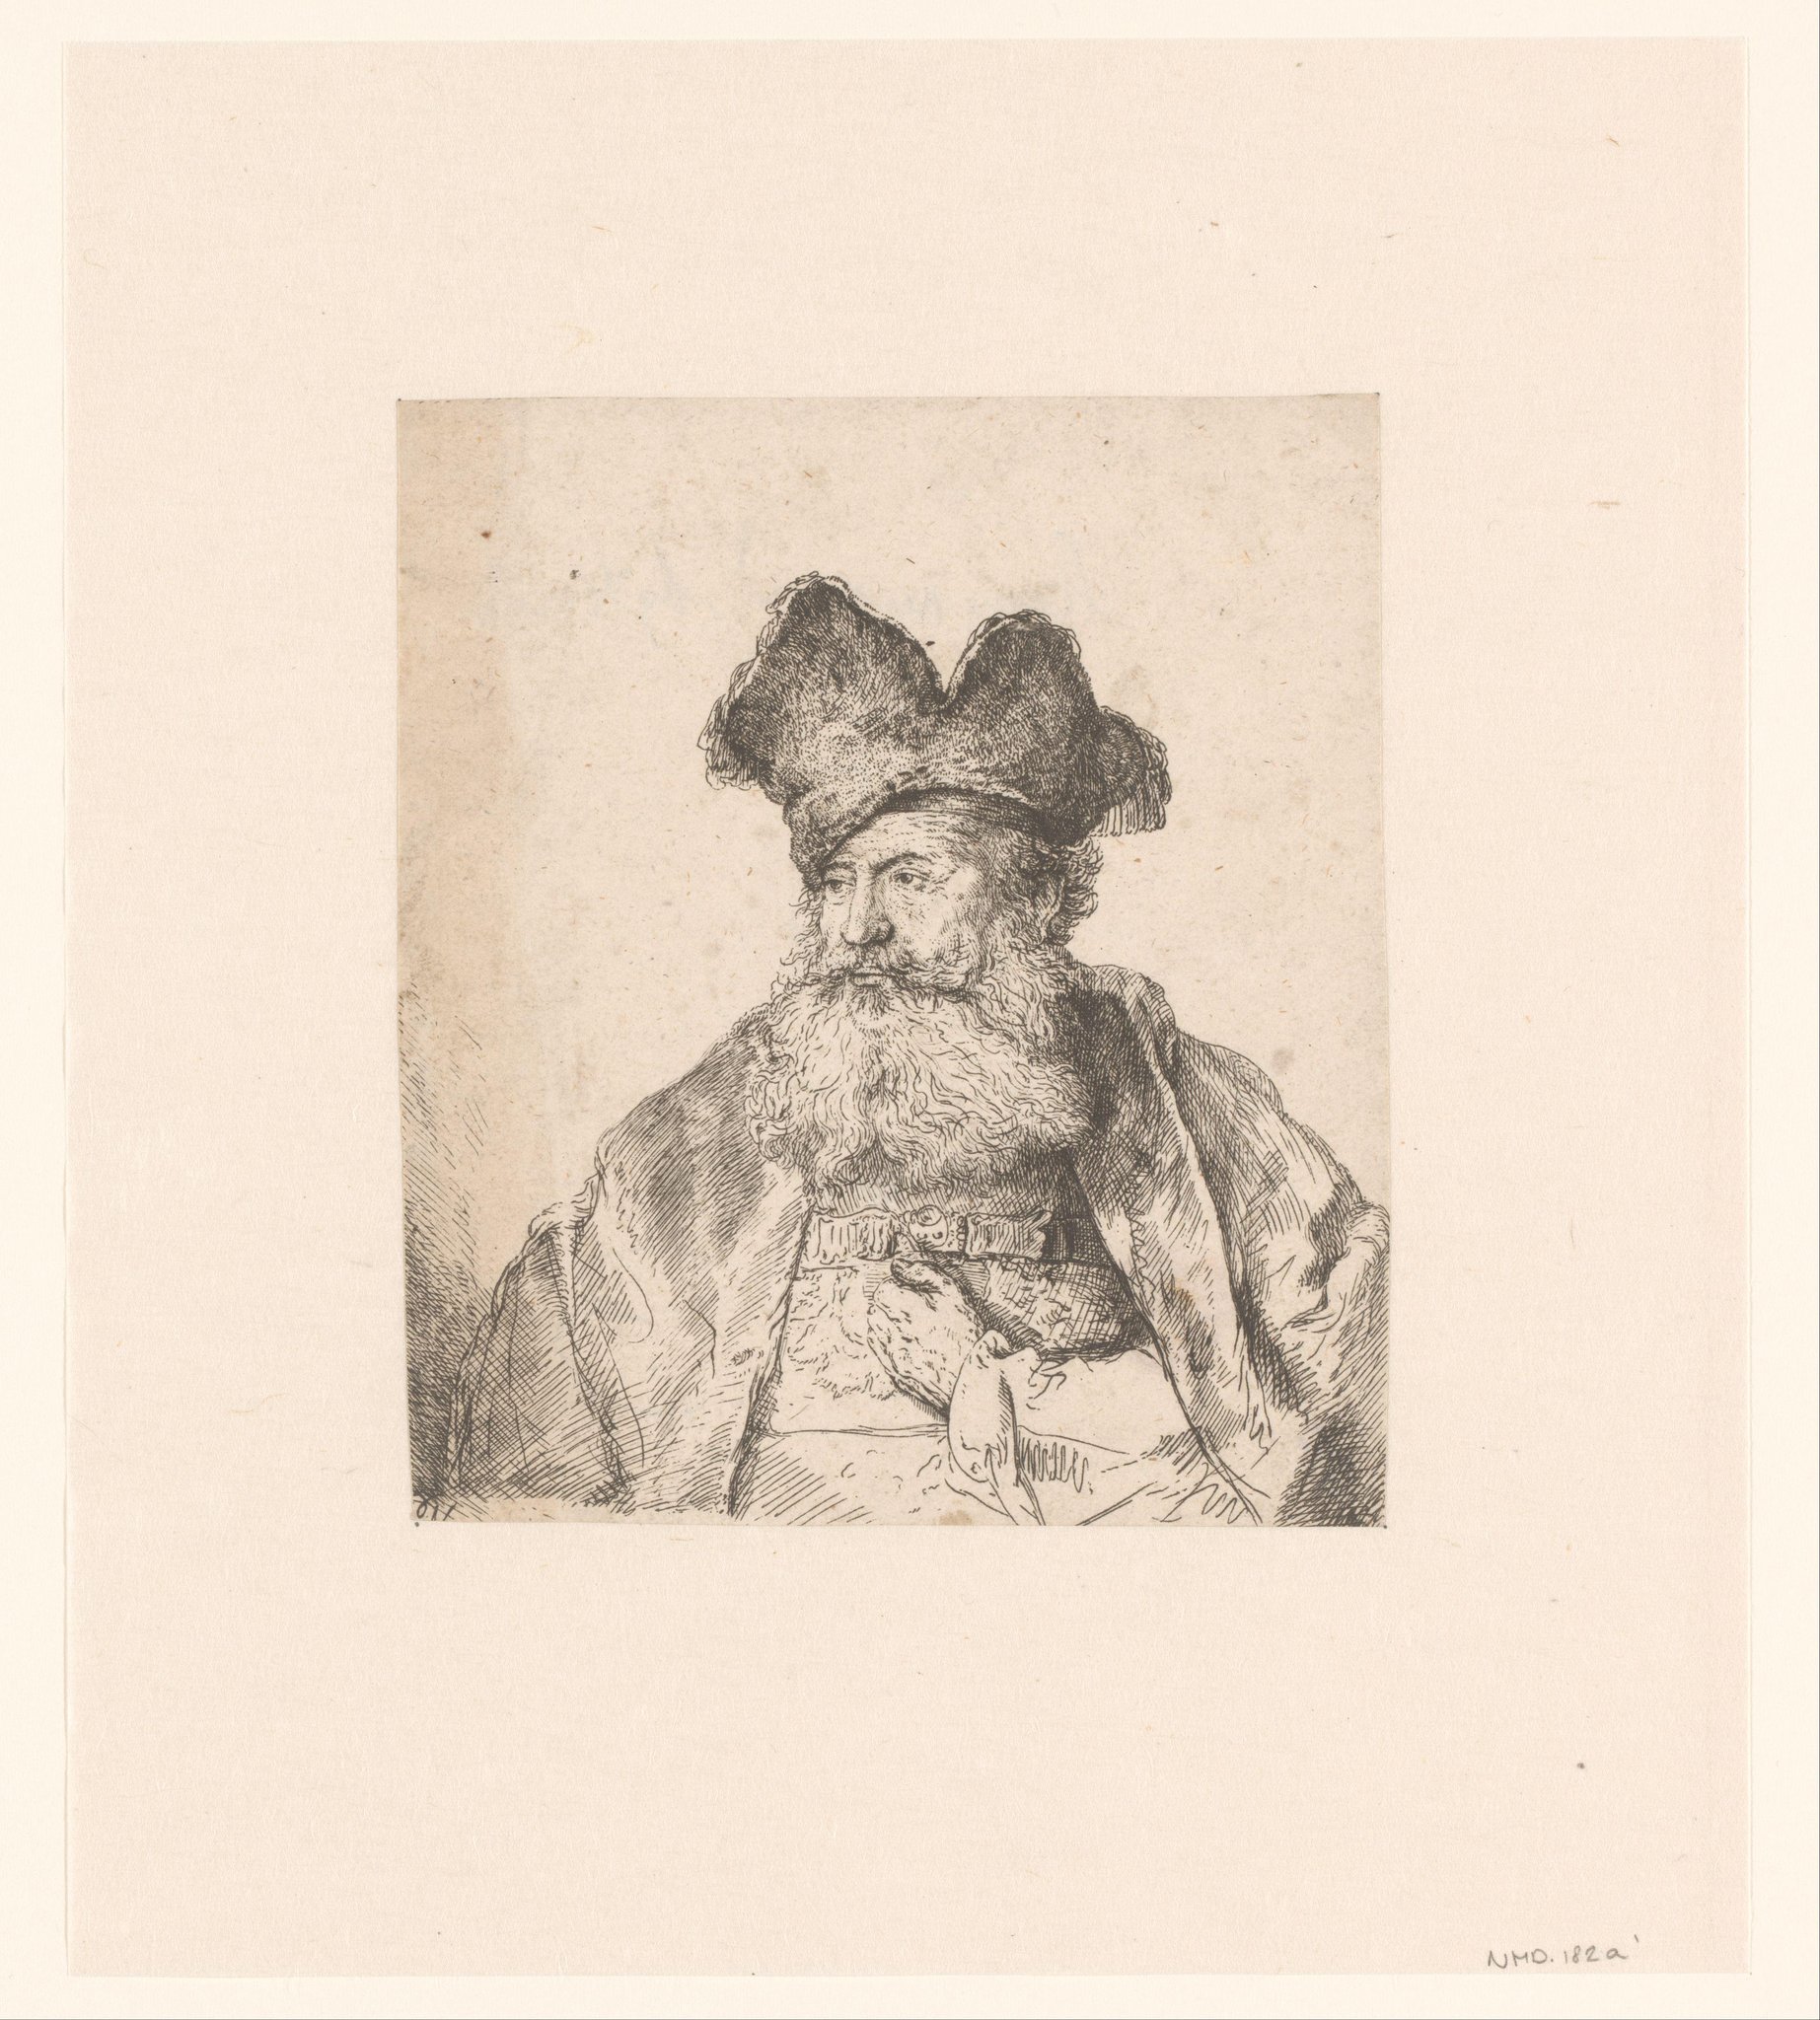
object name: print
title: Old man with a divided fur cap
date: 1761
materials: paper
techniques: etching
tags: head-gear (with name), old man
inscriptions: collector's mark: Lugt 2228, collector's mark: Lugt 2760, collector's mark: 3834, collector's mark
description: Spiegelbeeldige kopie naar de gelijknamige prent van Rembrandt.